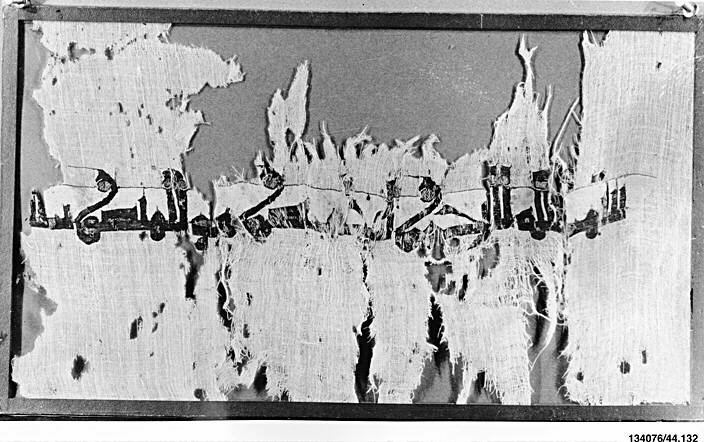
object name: textile fragment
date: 975-996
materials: linen, metal thread, silk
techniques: tapestry, weave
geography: egypt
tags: arabic